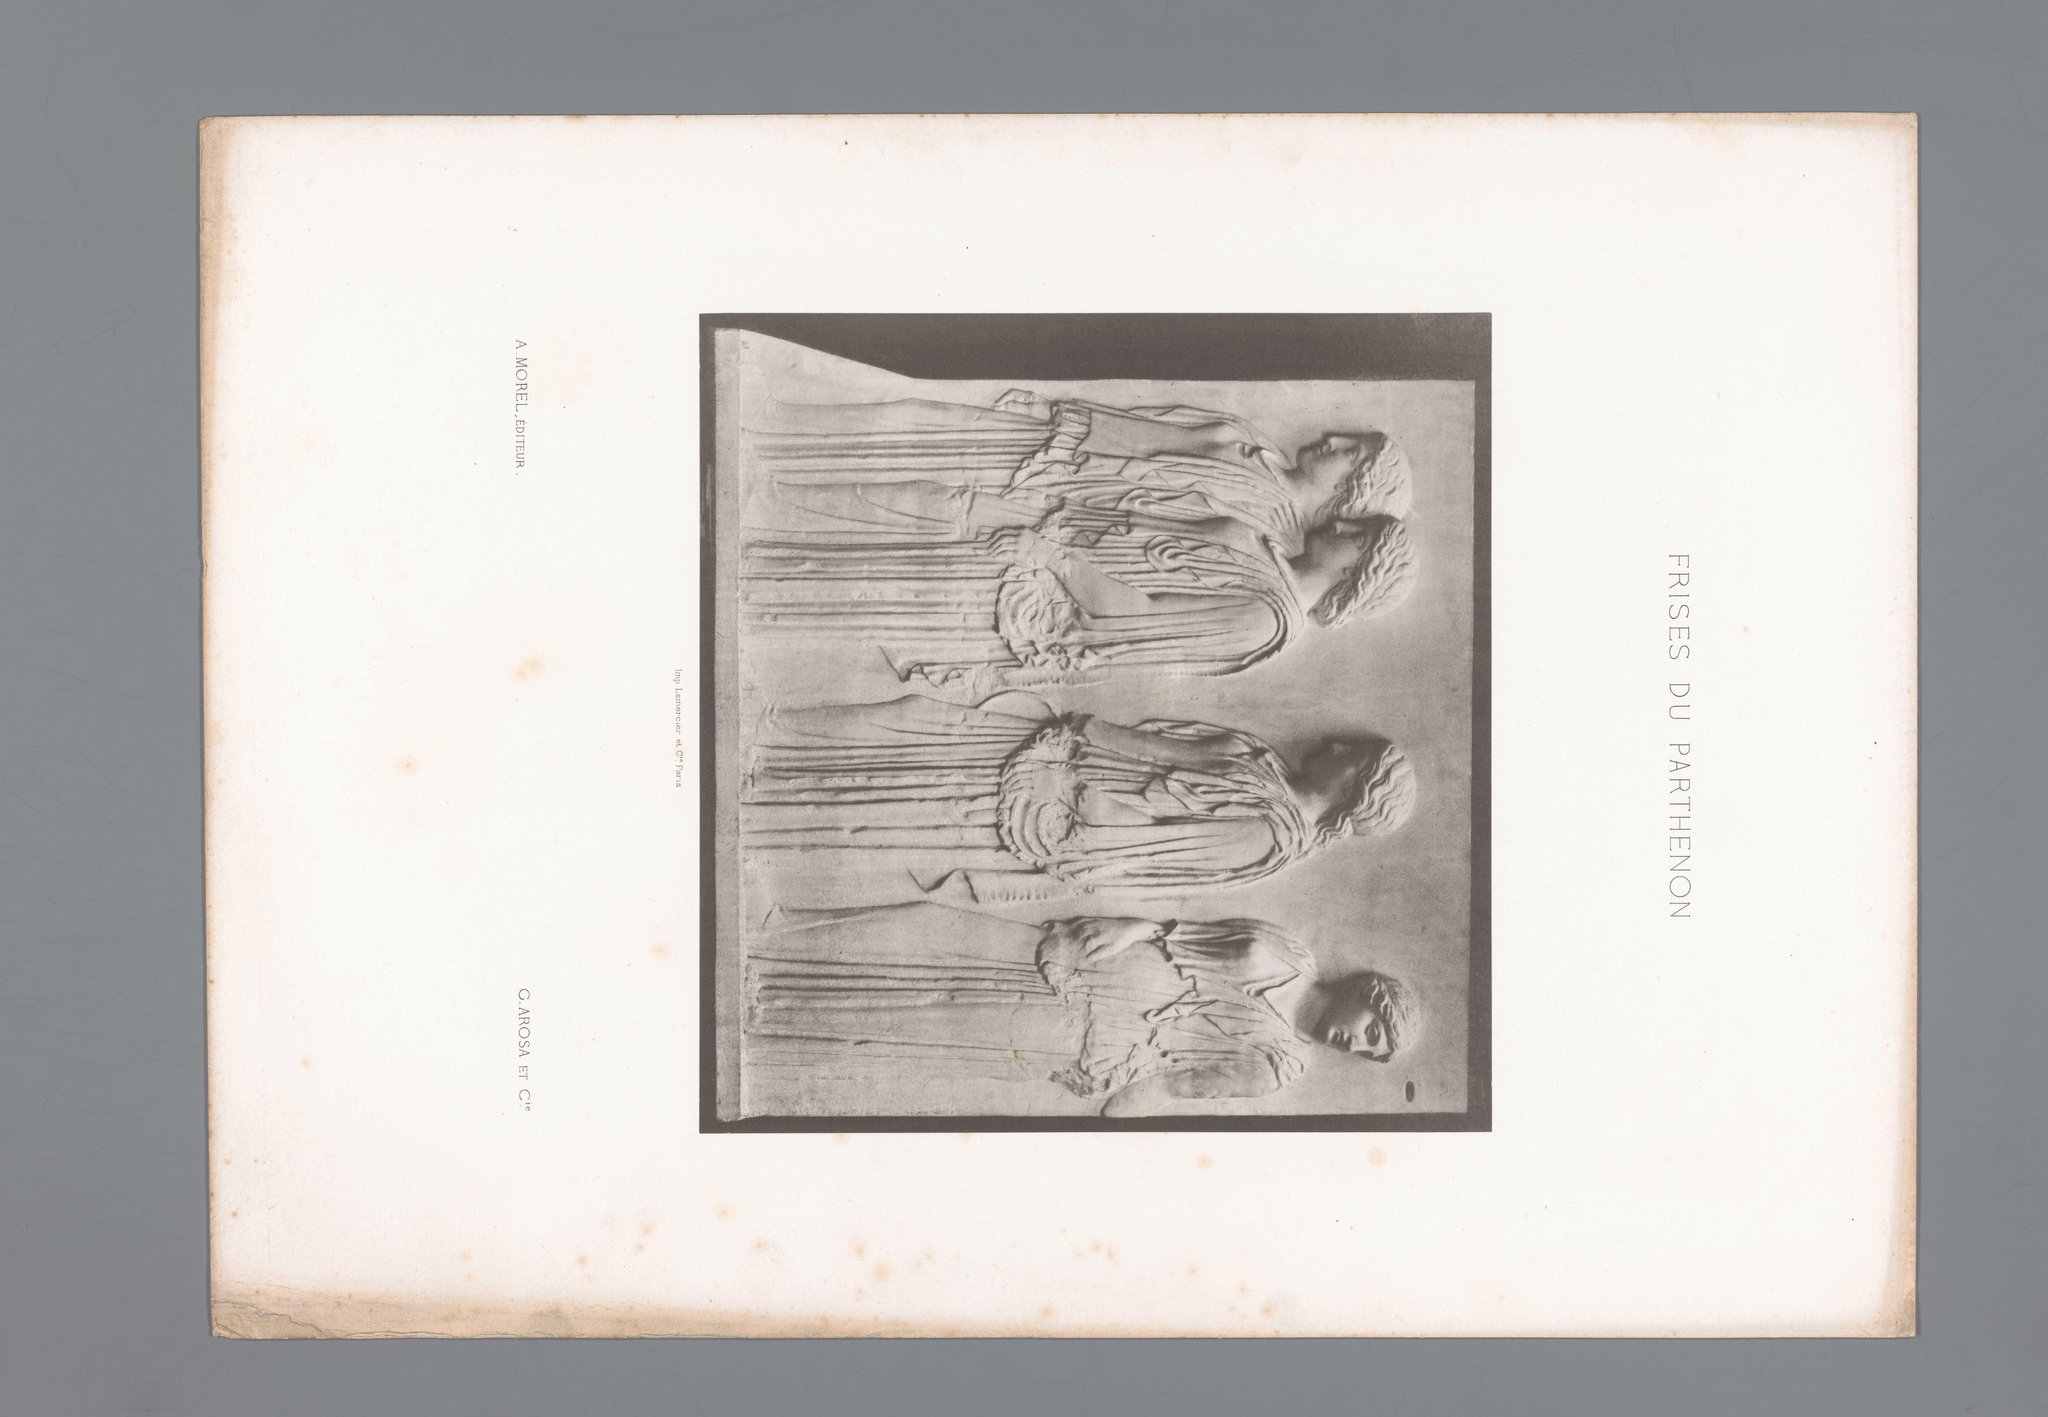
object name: photomechanical print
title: Frises du Parthenon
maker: a. morel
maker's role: publisher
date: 1863-1868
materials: paper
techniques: photograph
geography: paris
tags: mouldings ~ architecture, adult woman (+ four persons)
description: Deze prent maakt deel uit van een omslag met 22 prenten en 3 tekstbladen.